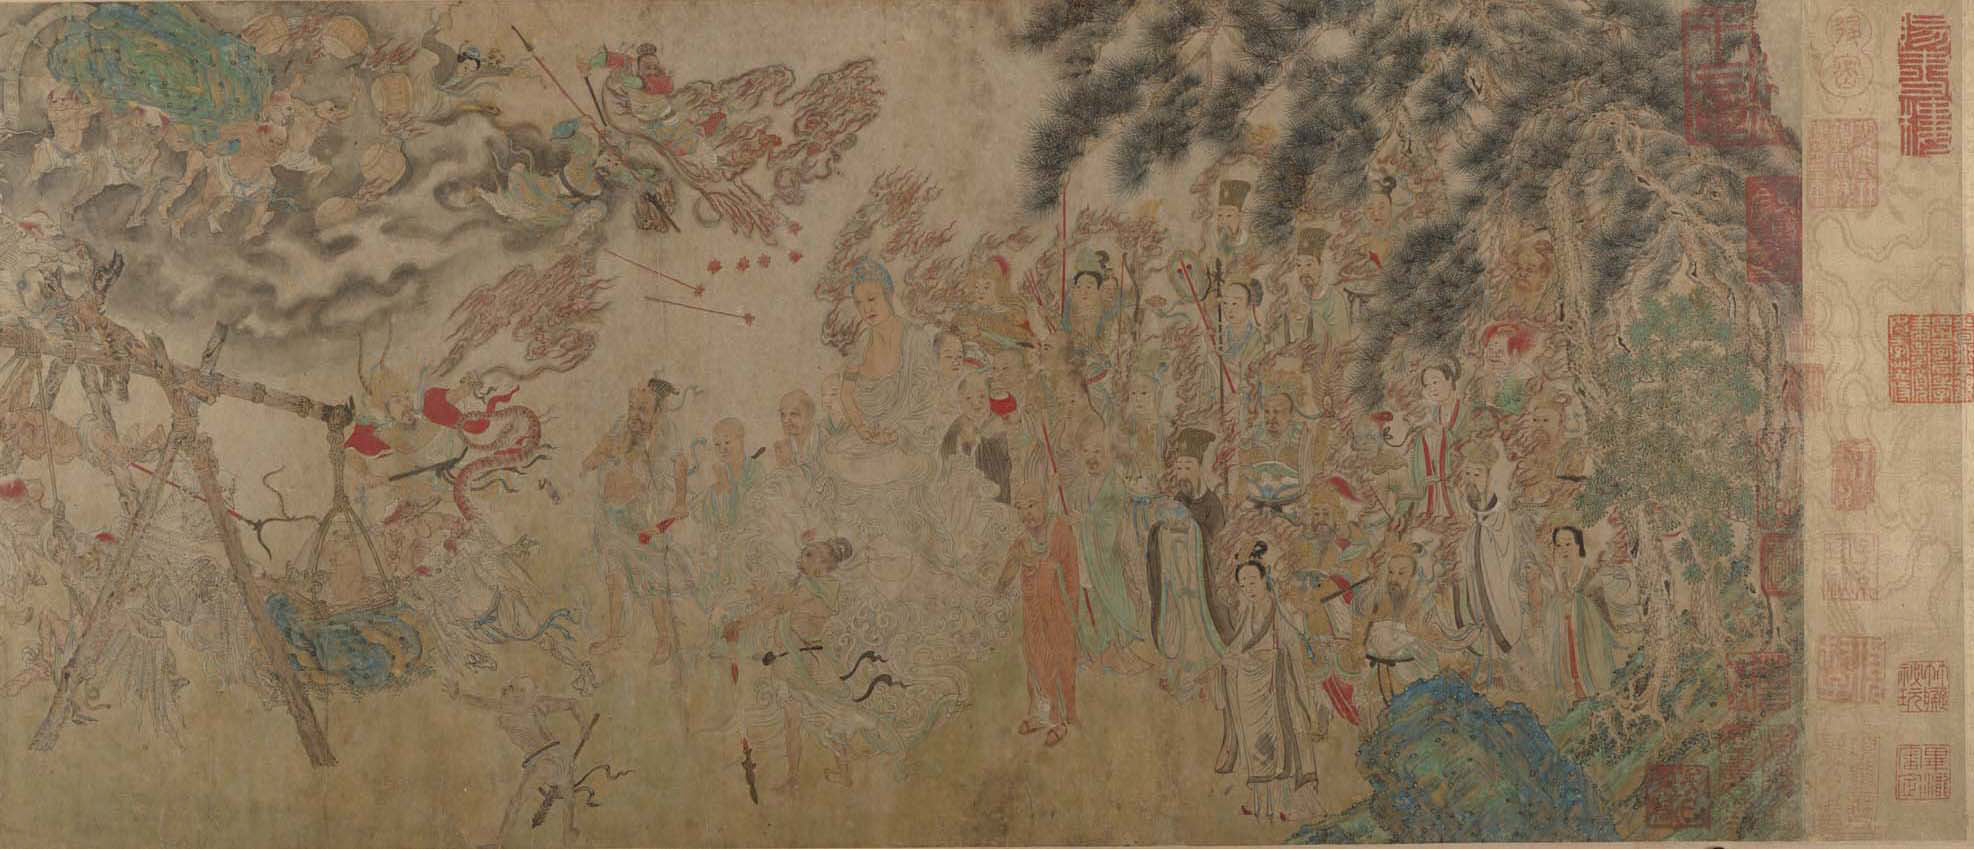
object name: handscroll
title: Raising the Alms-Bowl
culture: chinese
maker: unidentified artist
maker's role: artist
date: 1601-1800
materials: gold, ink, paper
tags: men,women,buddhism,buddha,demons